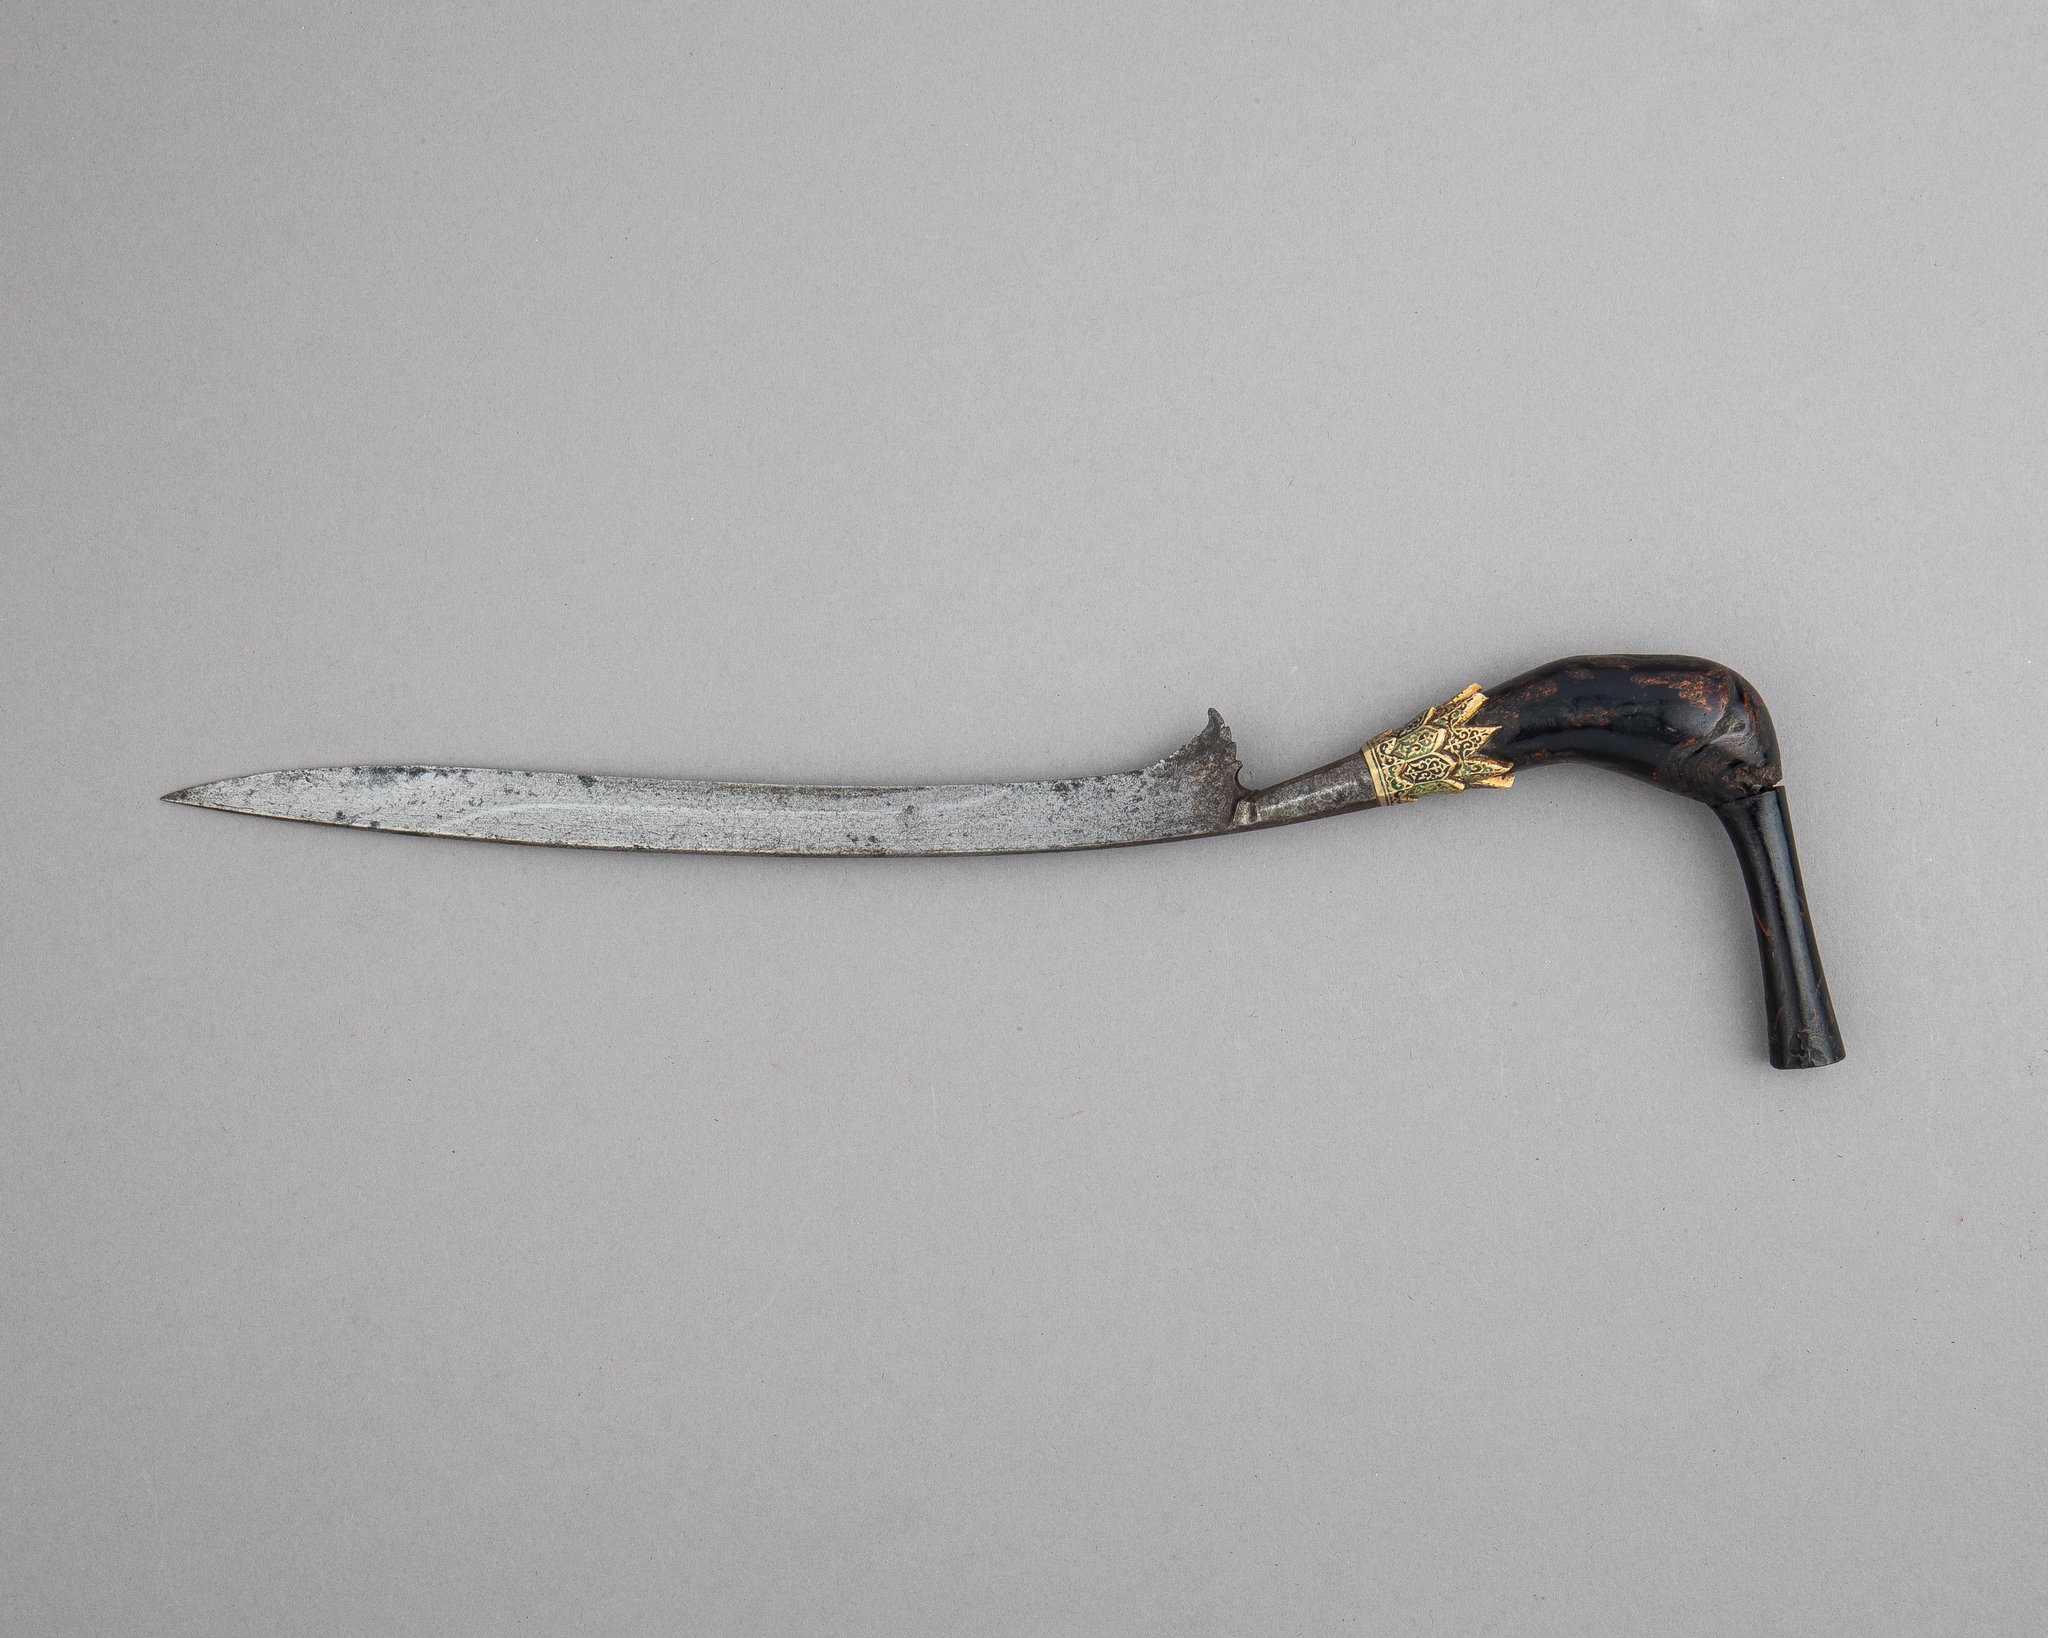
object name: knife bade bade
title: Knife (Bade-bade)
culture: sumatran or acheen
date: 1501-1900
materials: gold, horn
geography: indonesia